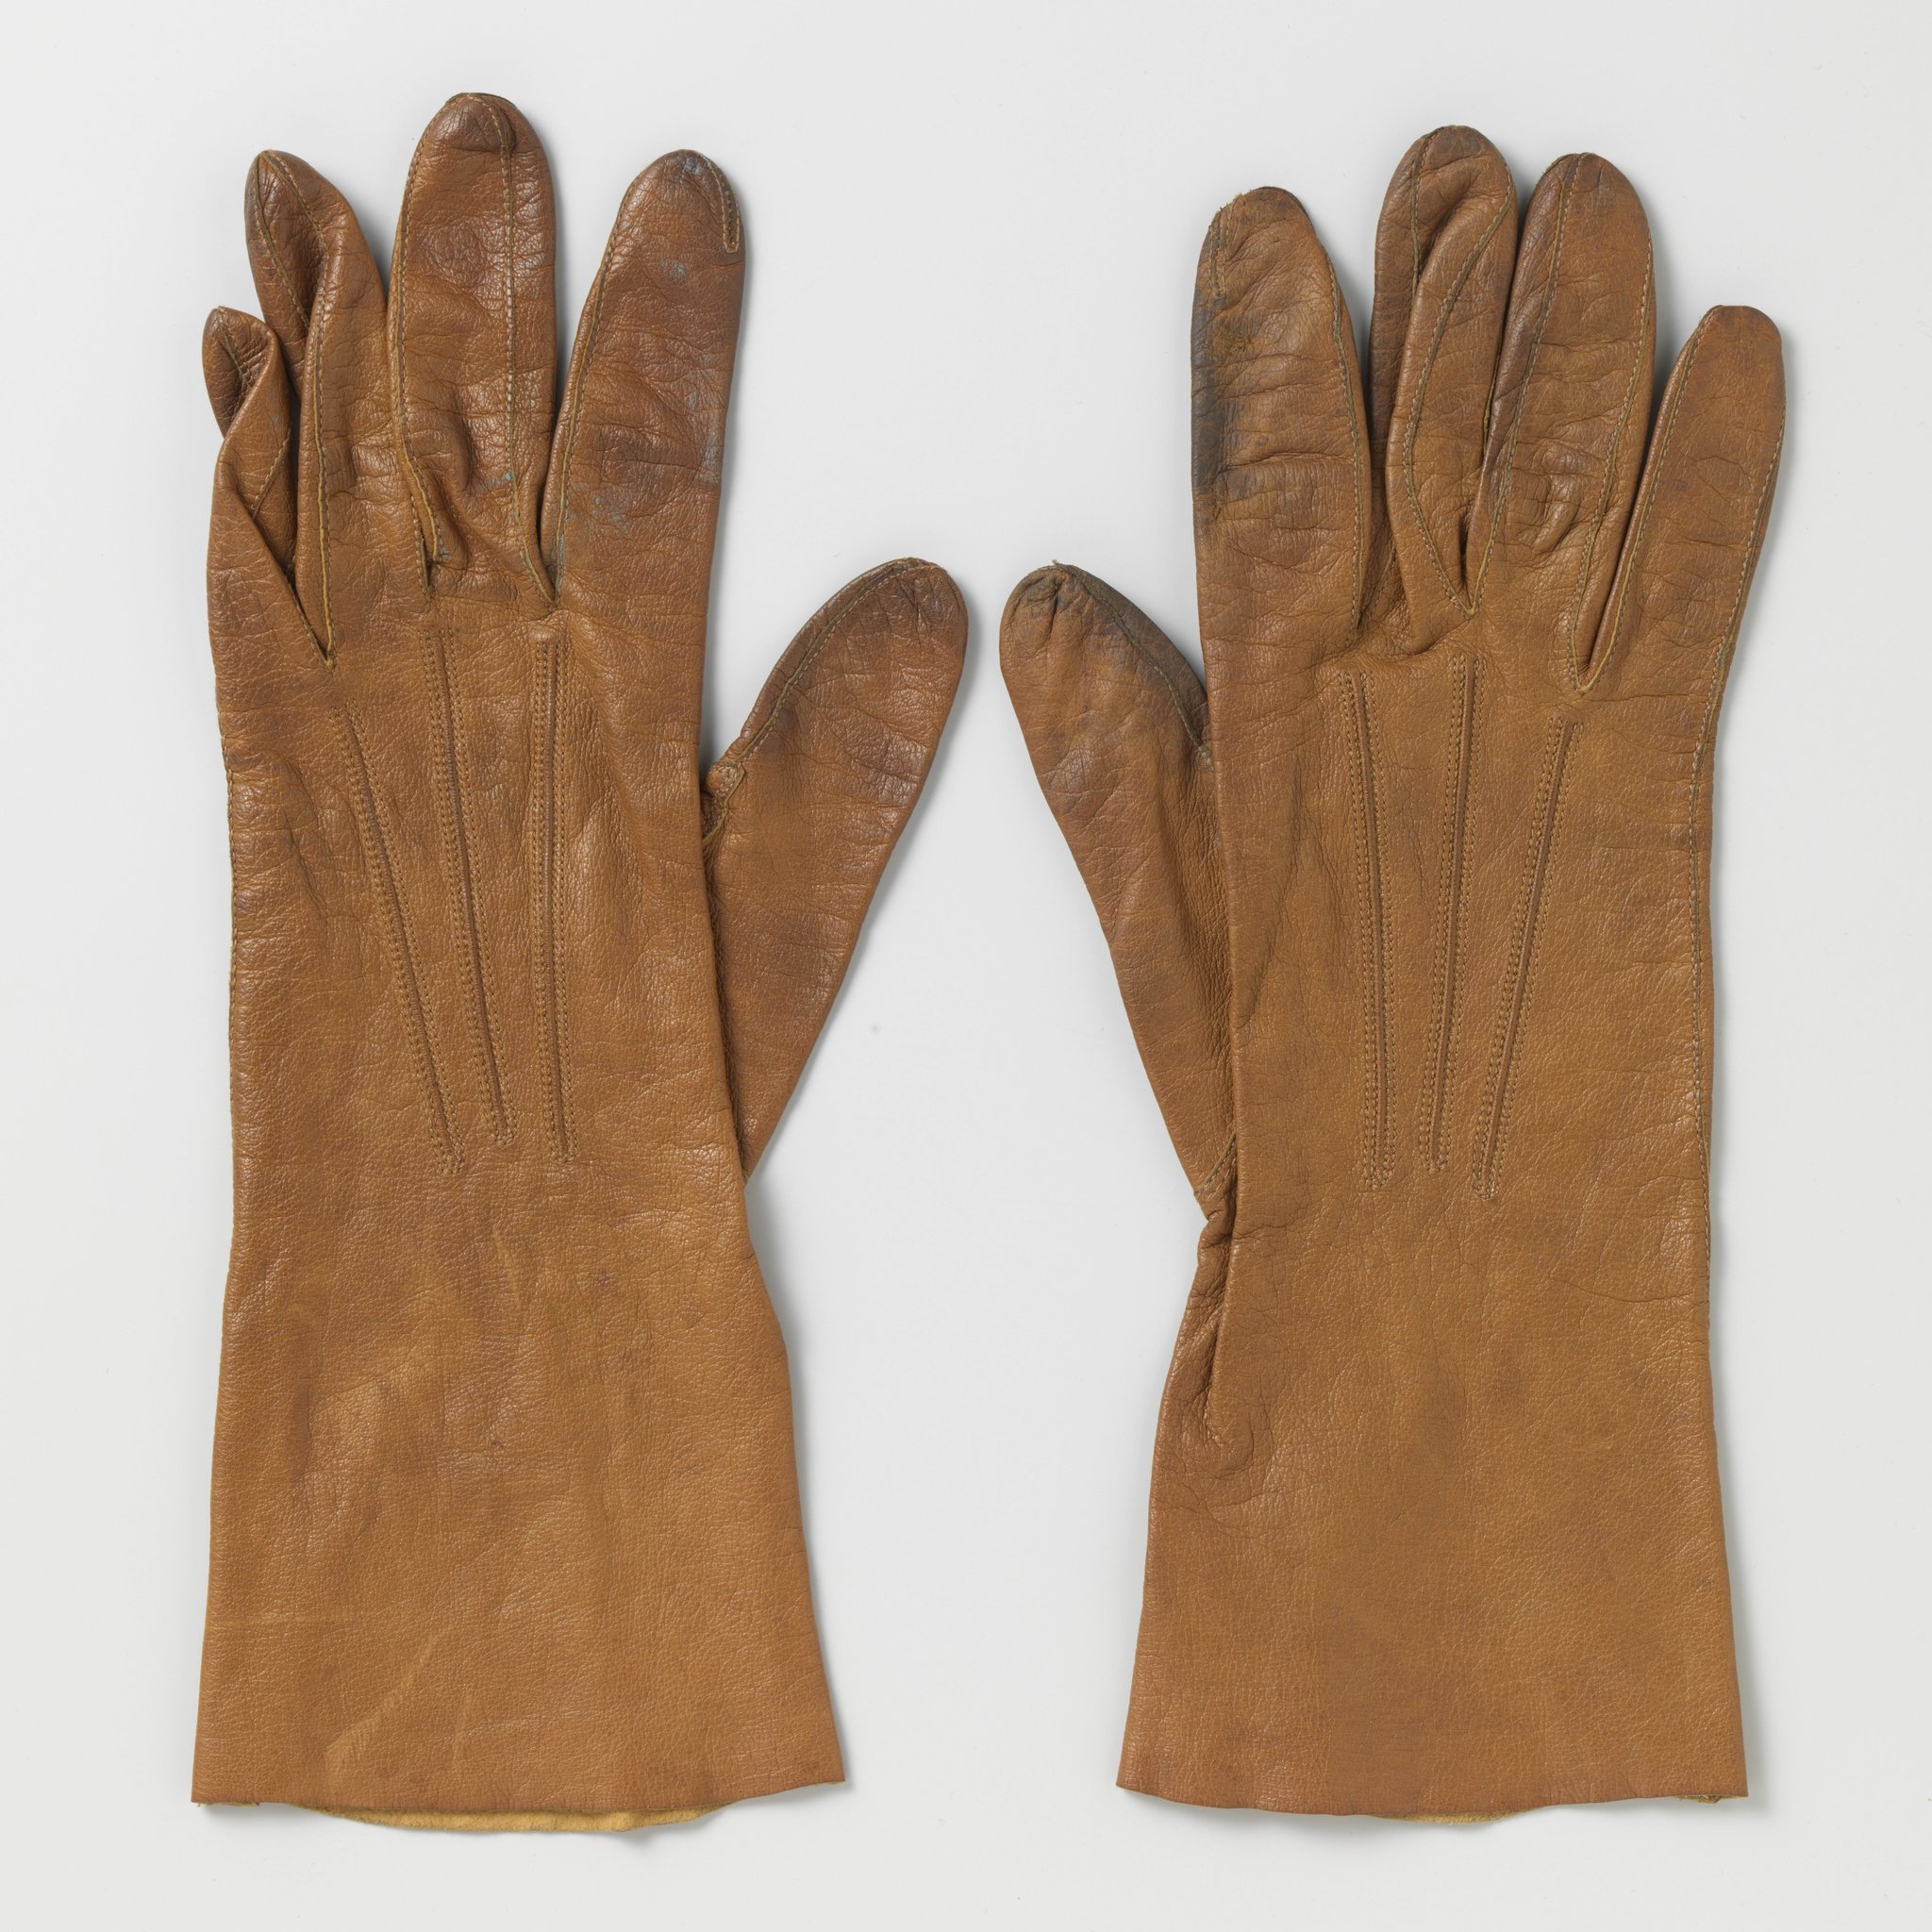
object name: glove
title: Pair of gloves with radiating cords on the back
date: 1900-1915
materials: leather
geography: netherlands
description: Linker handschoen van bruin leer, met op de rug drie uitstralende koorden.